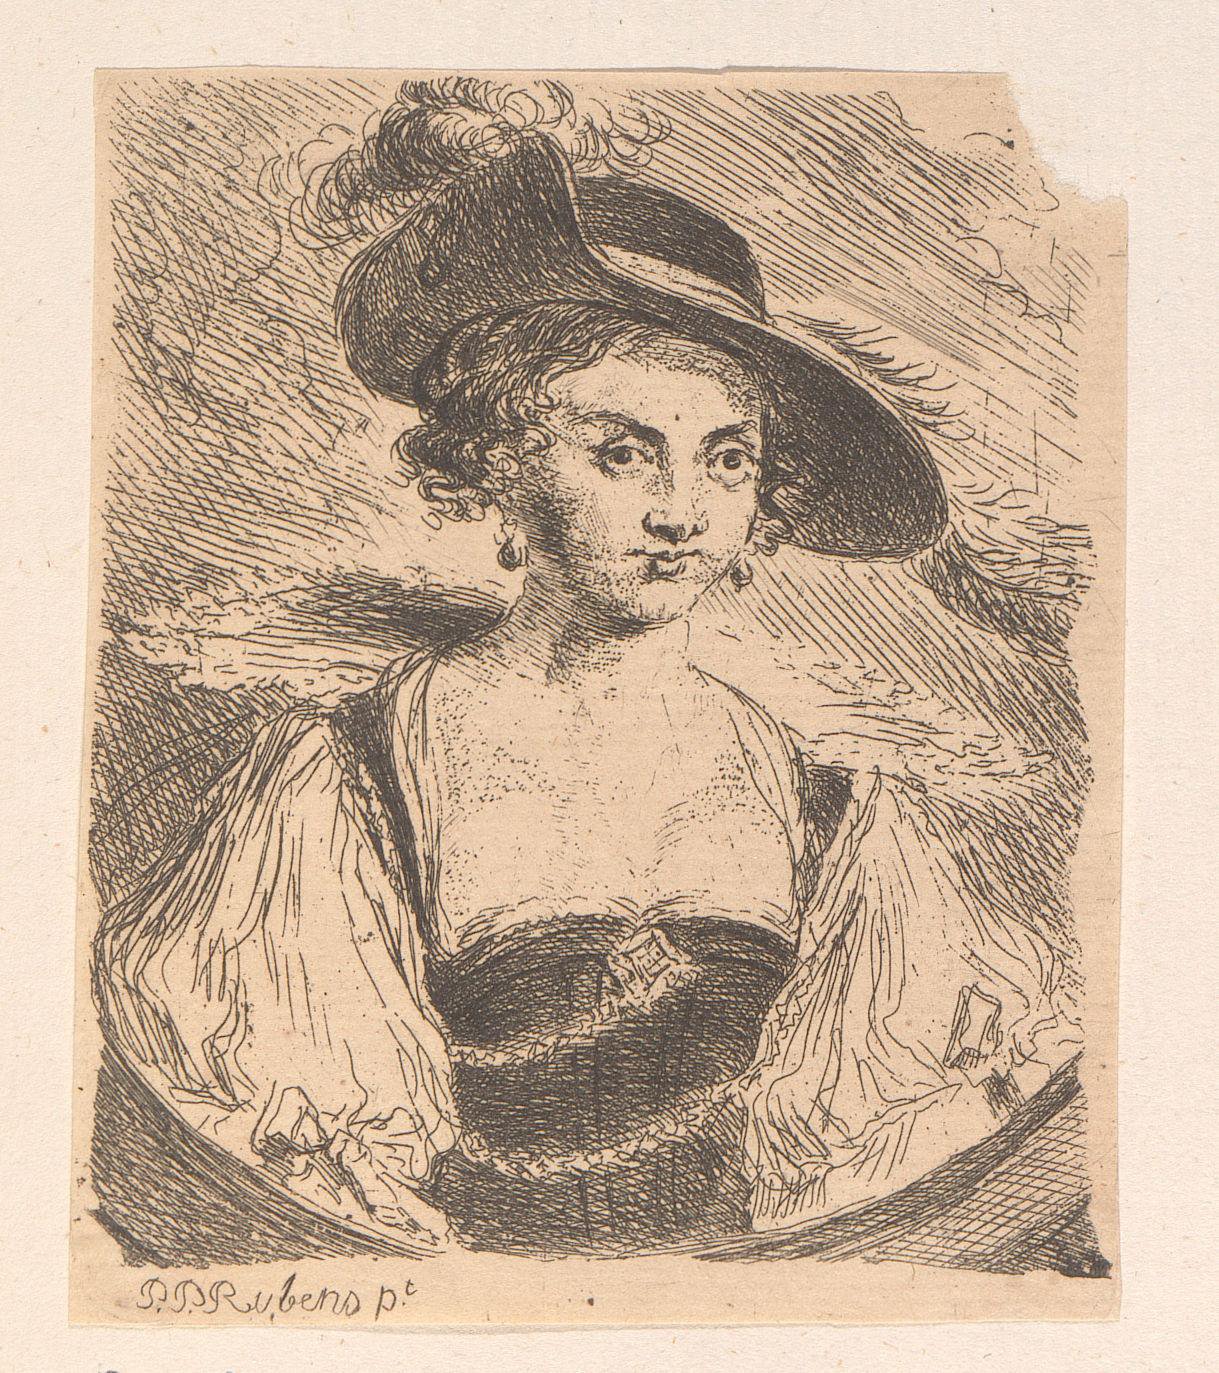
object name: print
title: Portret van Helena Fourment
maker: peter paul rubens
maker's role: draughtsman, painter, print maker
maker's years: 1577-1640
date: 1635-1801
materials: paper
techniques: etching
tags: historical persons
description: Portret van Helena Fourment, de tweede echtgenote van de schilder Rubens, met een breedgerande hoed op het hoofd. Deze prent maakt deel uit van een album.